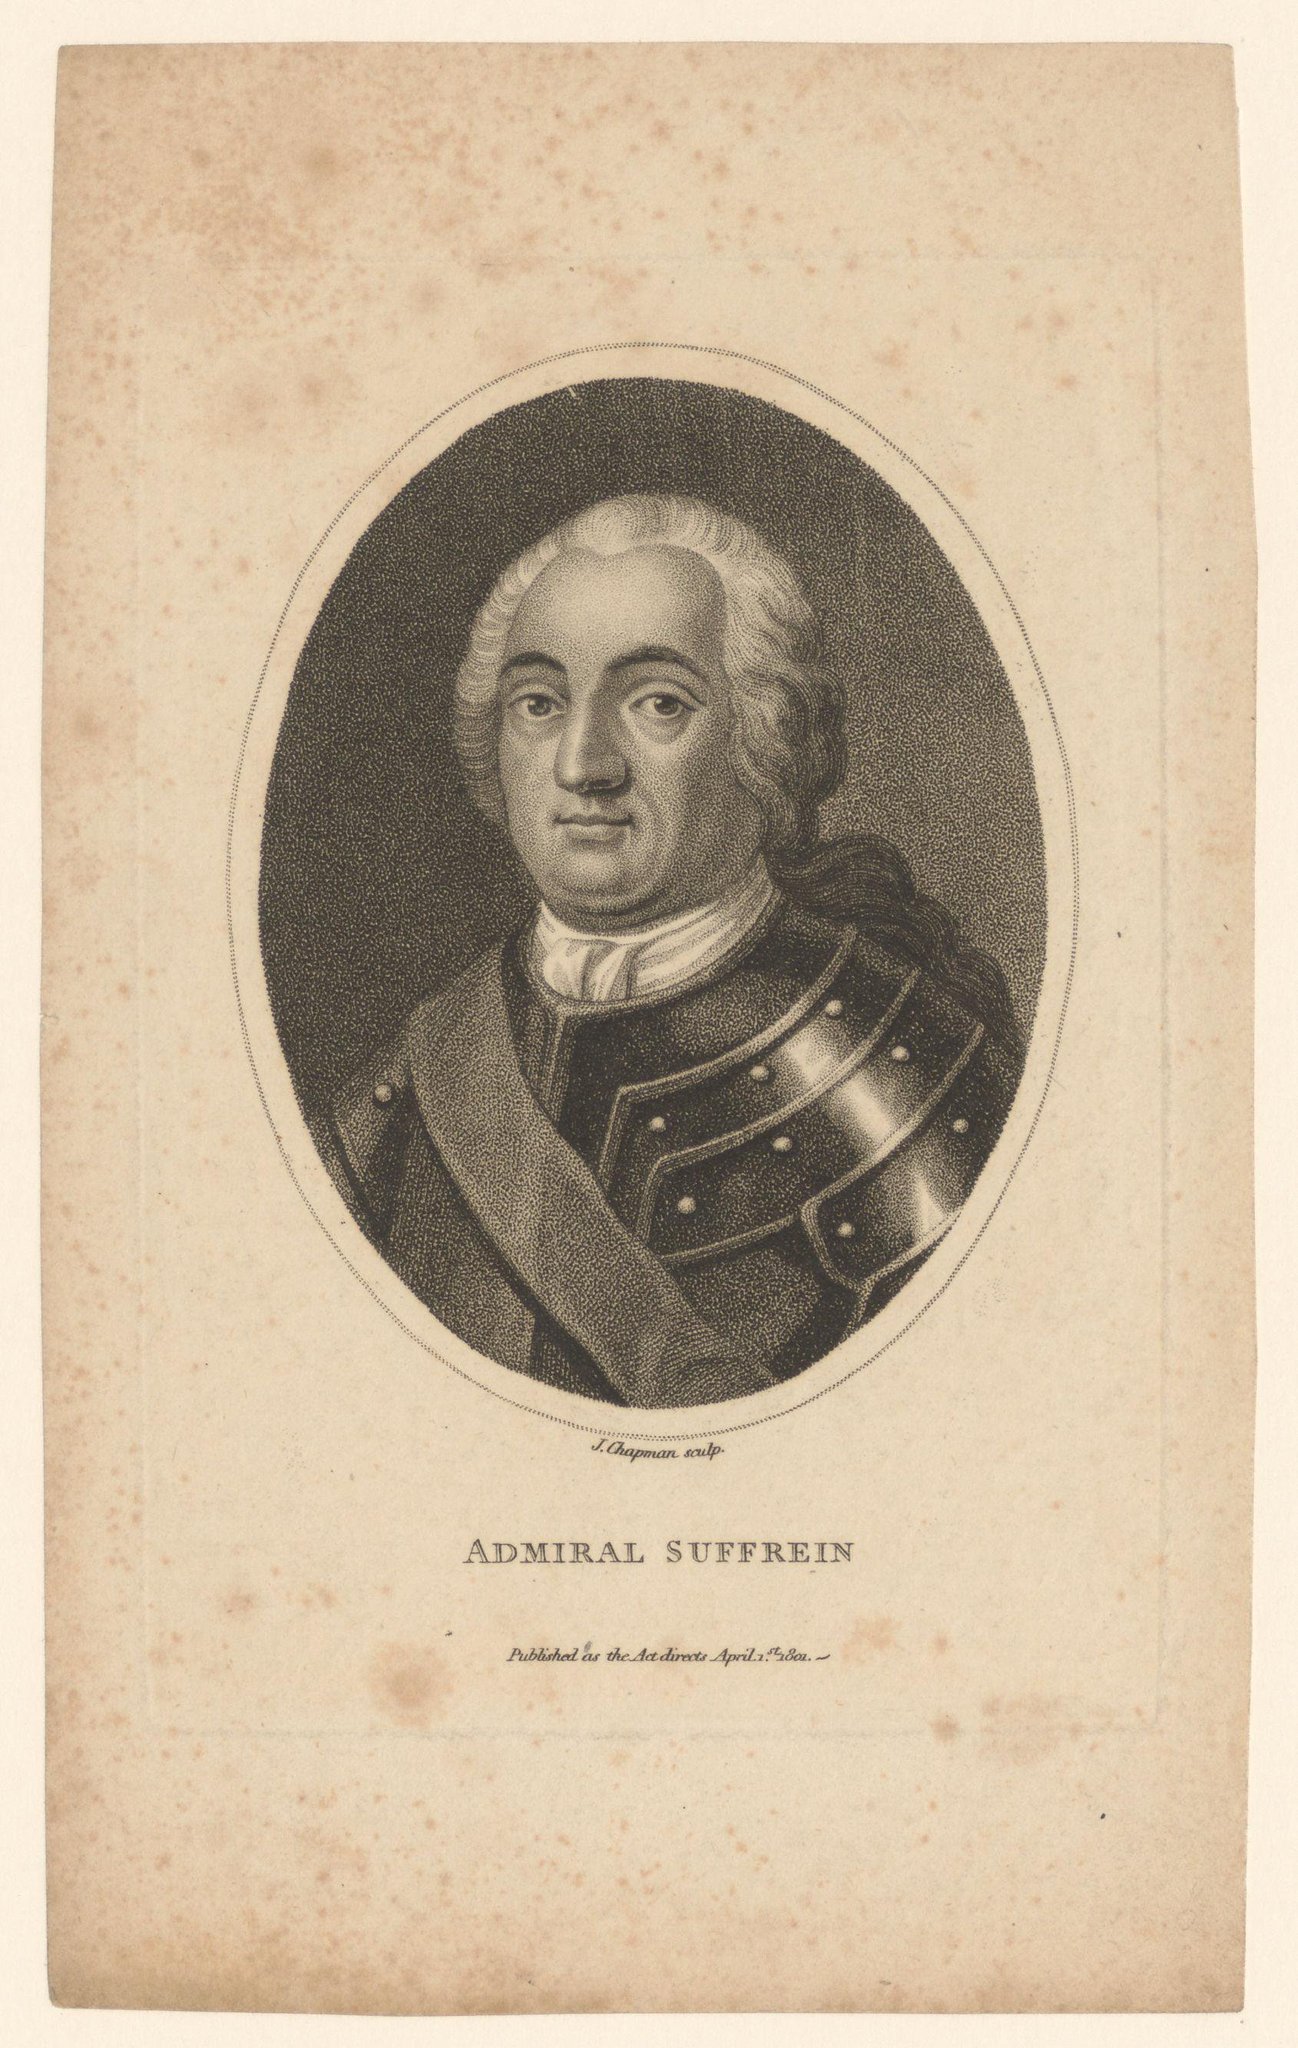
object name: print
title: Portret van Pierre André de Suffren de Saint-Tropez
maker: john chapman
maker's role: print maker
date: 1801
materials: paper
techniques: stippling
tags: paris, historical persons, commander-in-chief, admiral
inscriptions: collector's mark: Lugt 2228